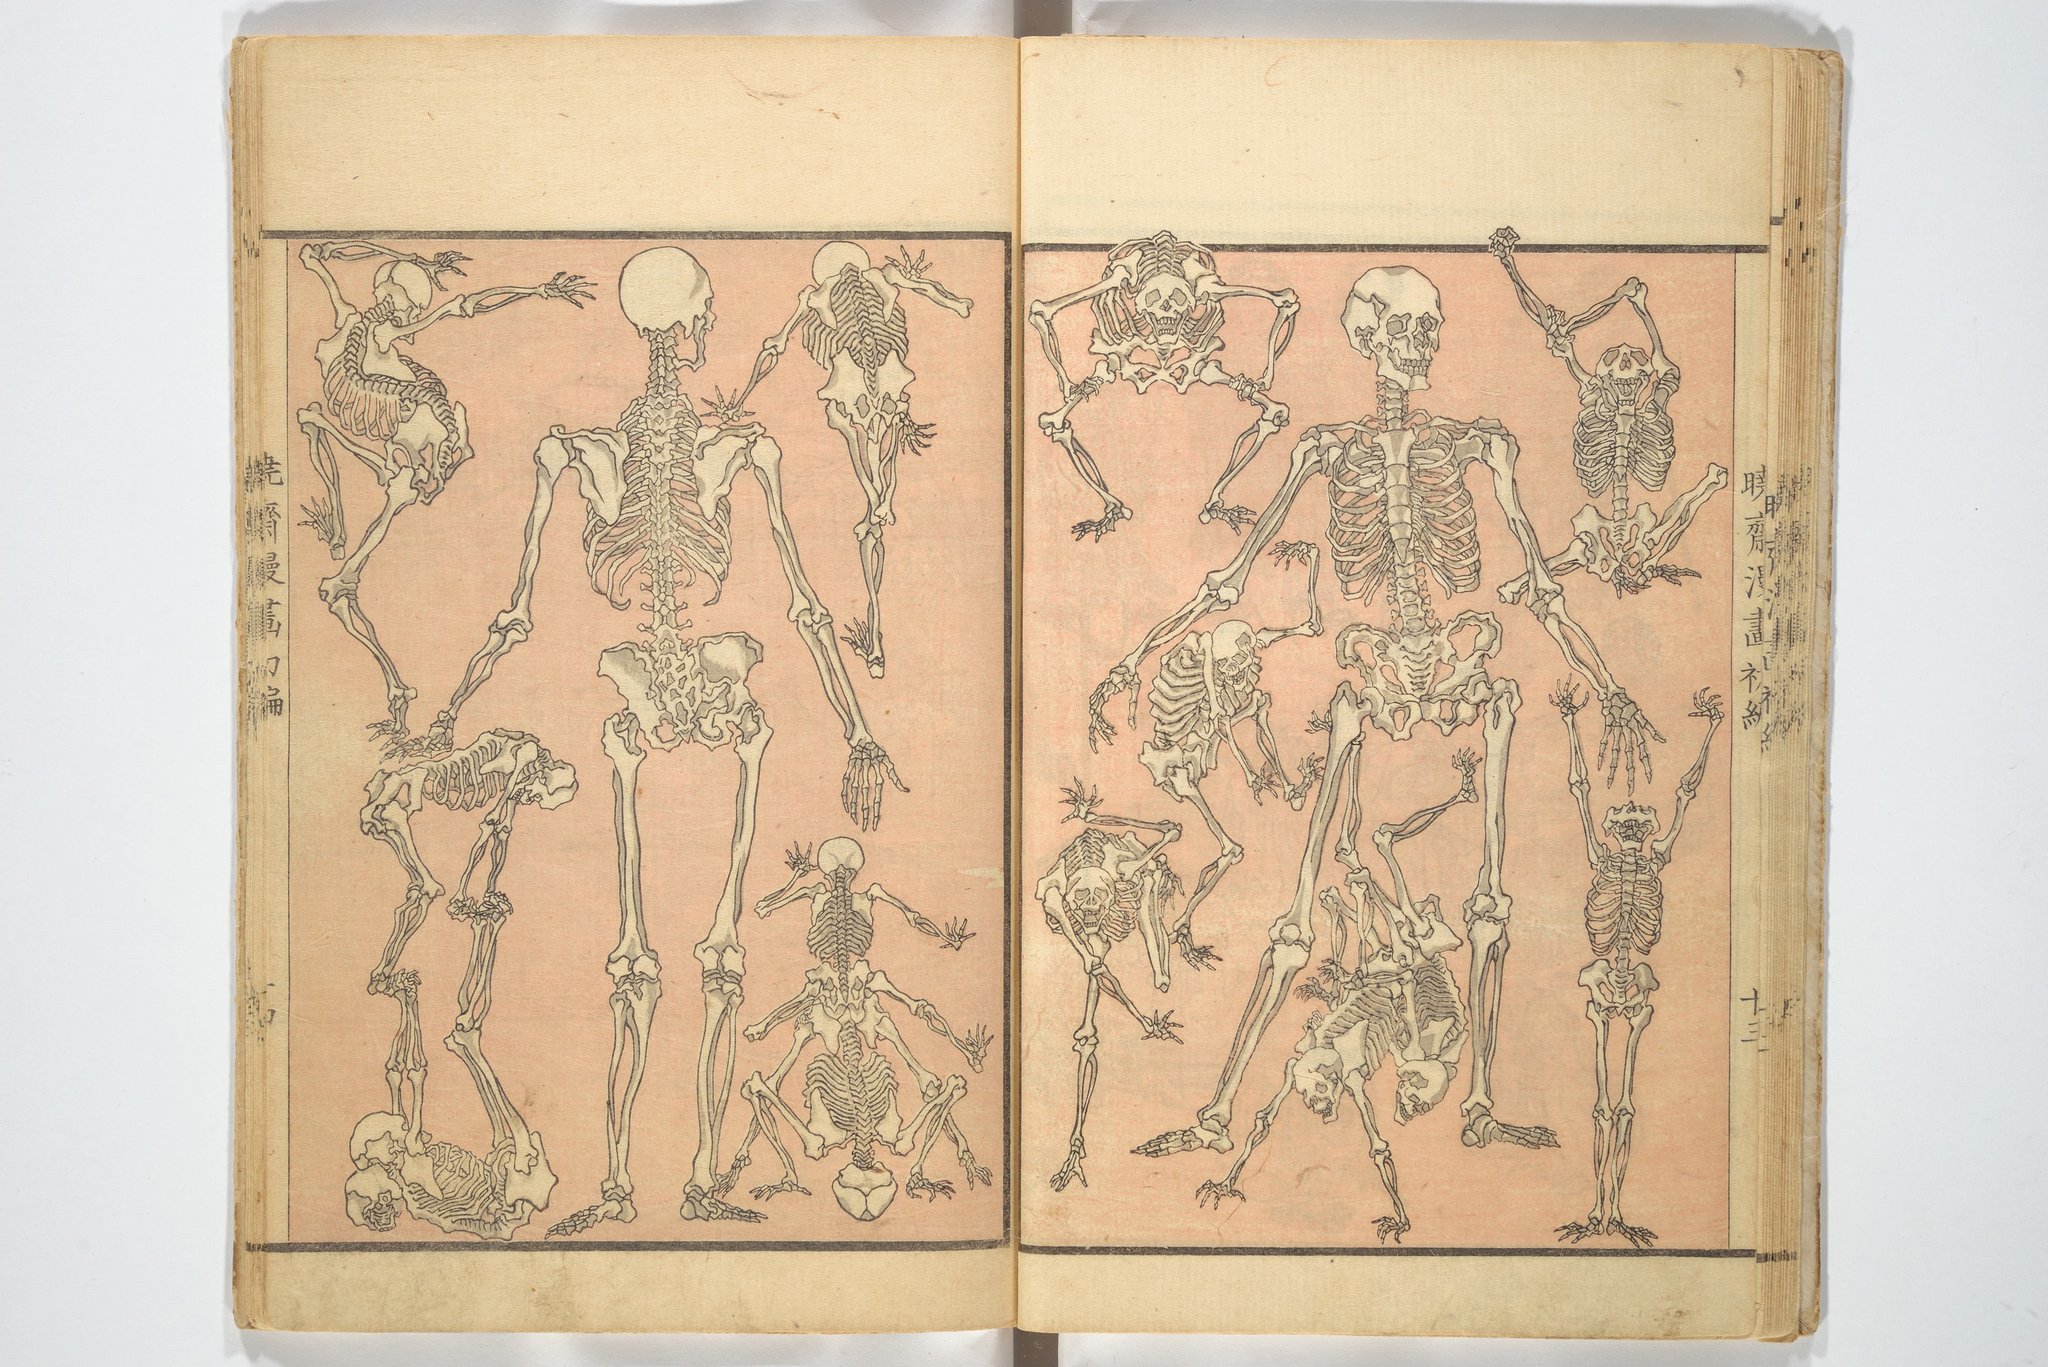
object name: illustrated book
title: Kyōsai Sketchbook (Kyōsai manga) 暁斎漫画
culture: japanese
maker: kawanabe kyōsai 河鍋暁斎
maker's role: artist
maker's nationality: japanese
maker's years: 1831-1889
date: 1881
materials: ink, paper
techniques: woodblock print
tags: skeletons